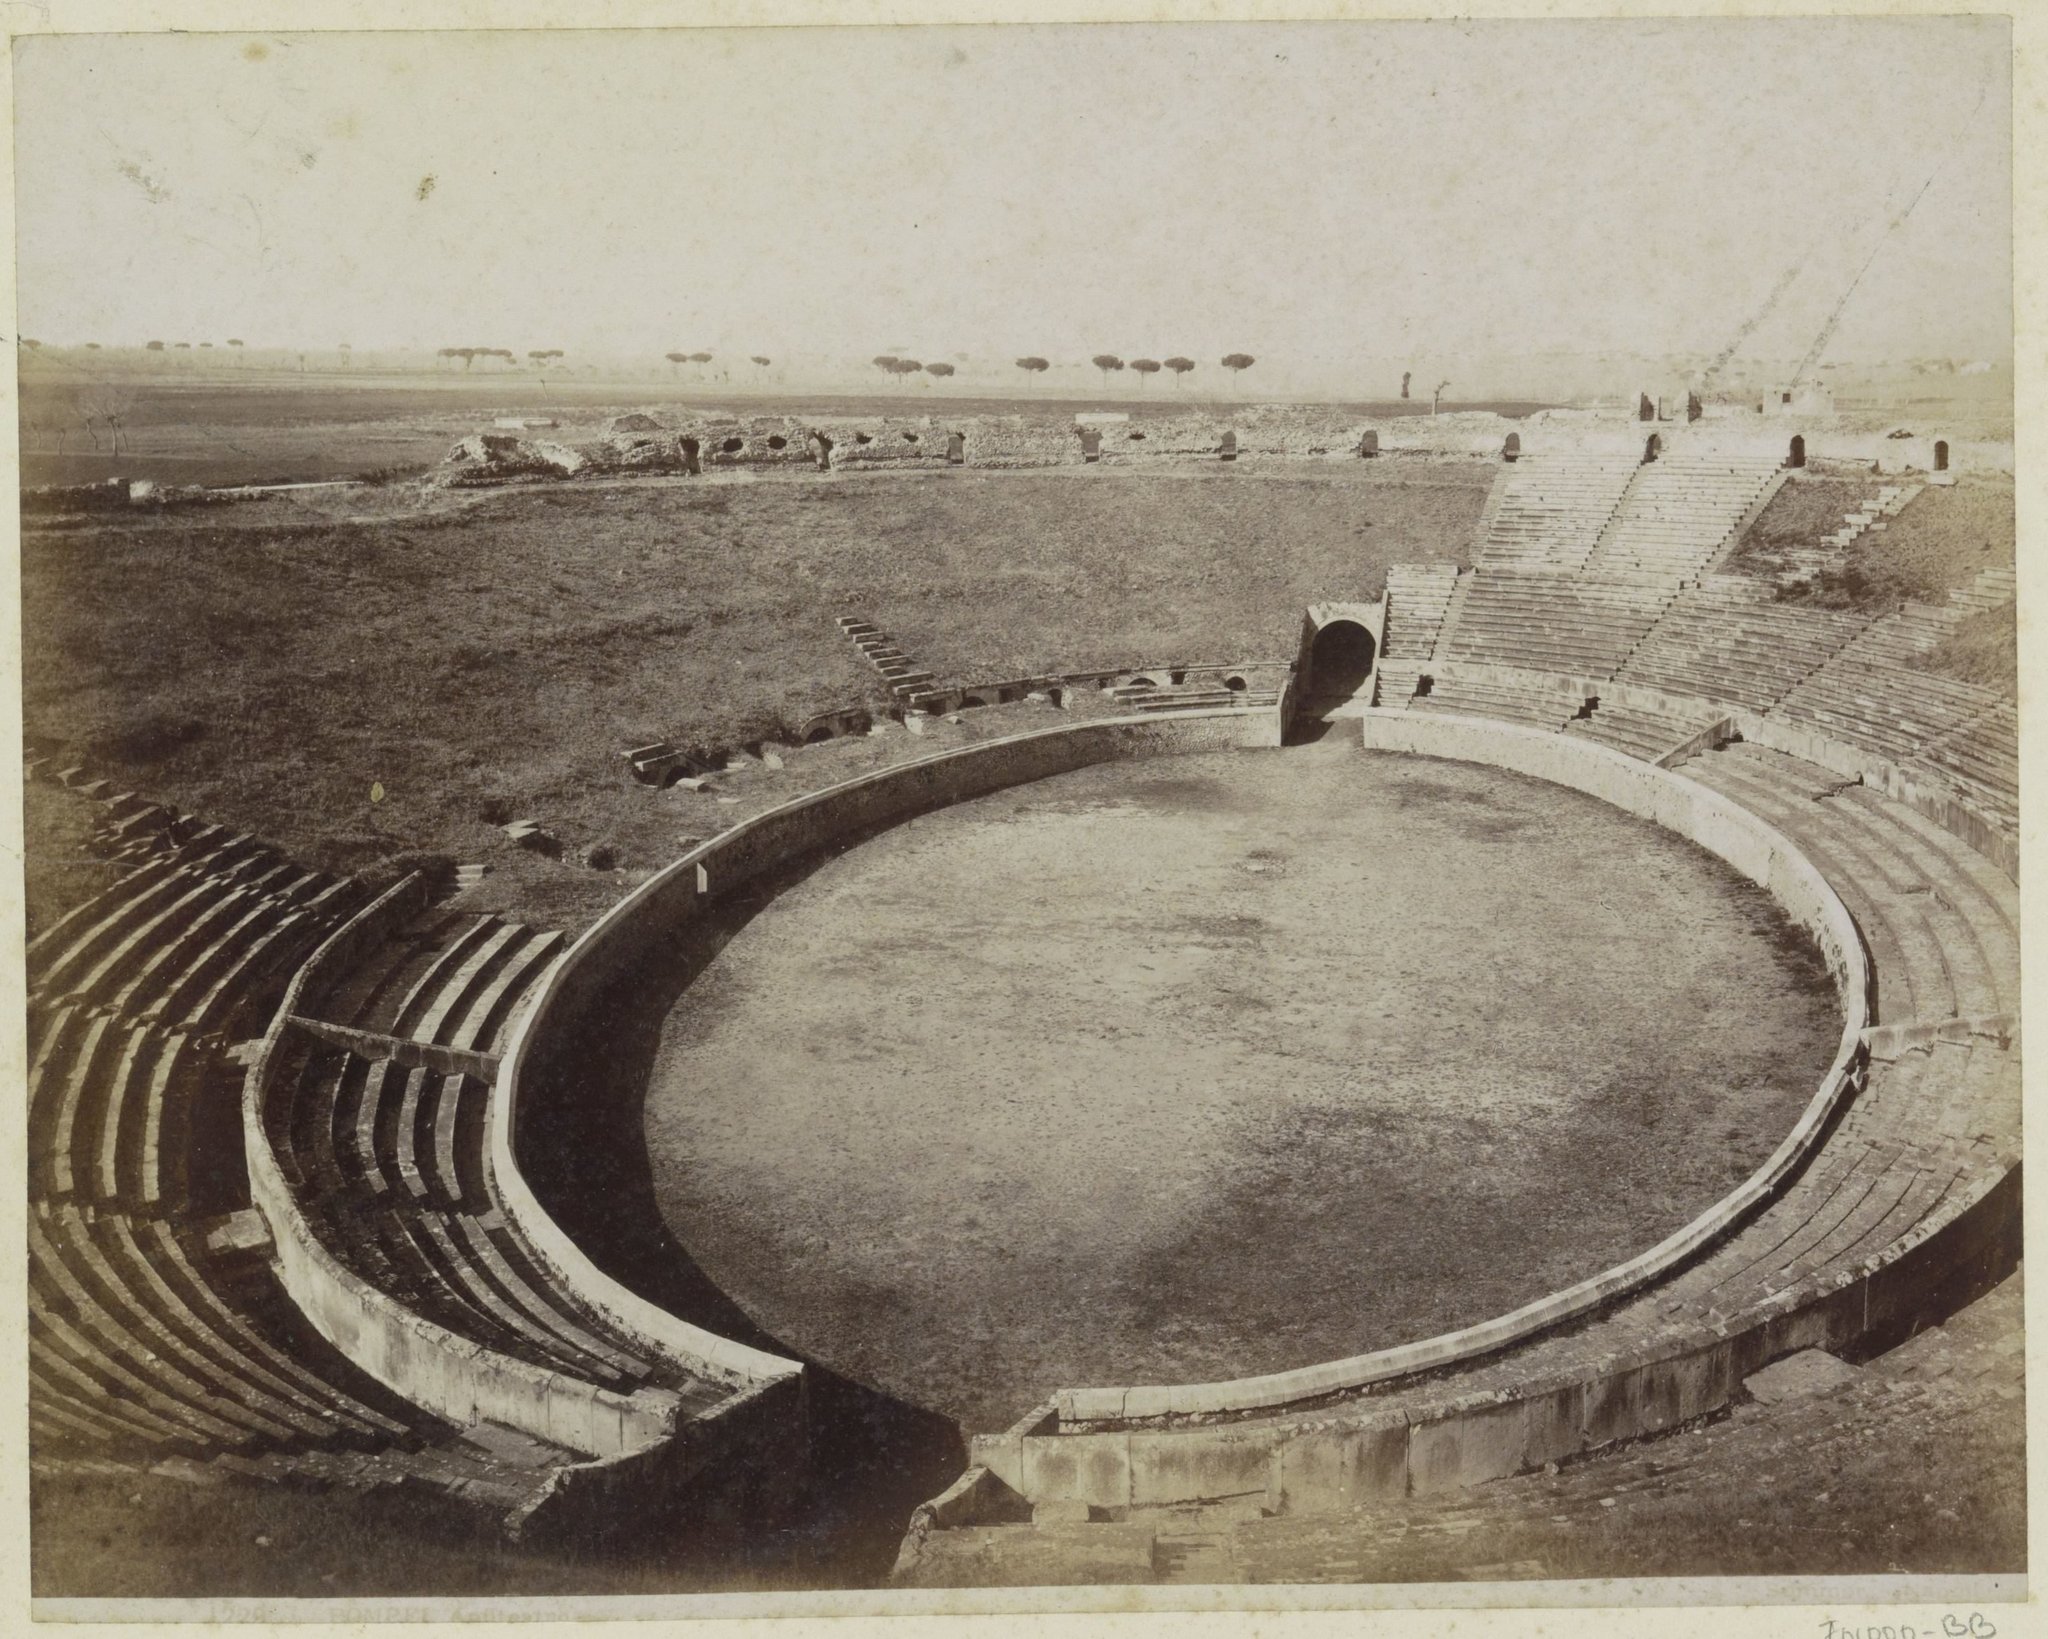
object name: photograph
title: POMPEI Anfiteatro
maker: giorgio sommer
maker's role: fotograaf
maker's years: 1834-1914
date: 1870-1900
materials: paper, photographic support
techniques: albumen print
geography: pompeii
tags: theatre (building) - aa - open-air performances, pompeii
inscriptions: negative number: ‘1229’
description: Onderdeel van Reisalbum met foto's van bezienswaardigheden in Italië en Frankrijk.